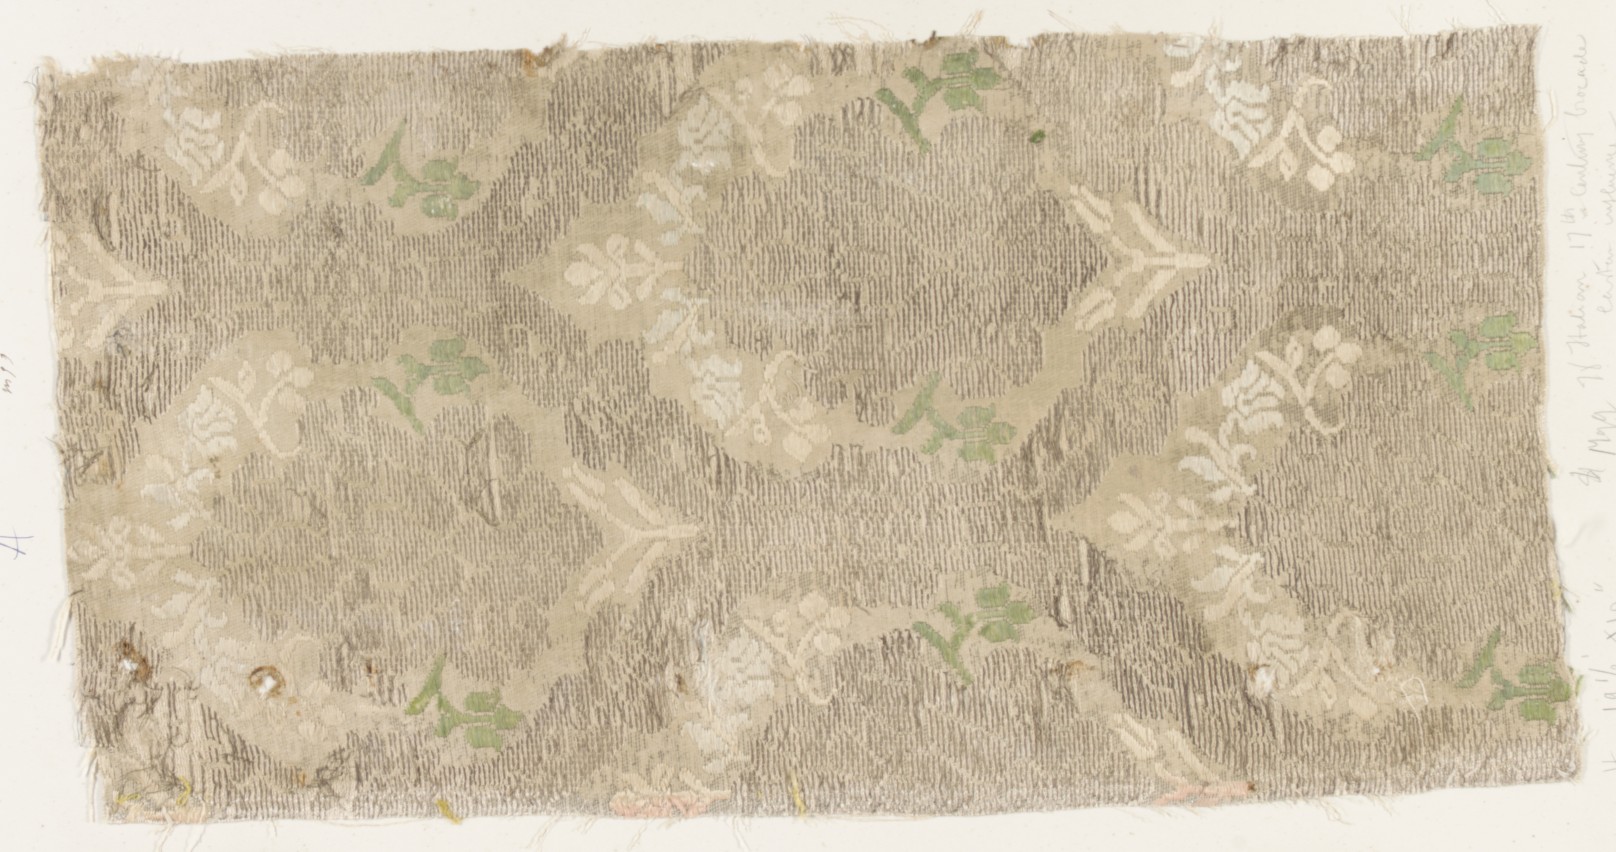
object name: fragment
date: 1601-1700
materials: metal thread, silk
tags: flowers